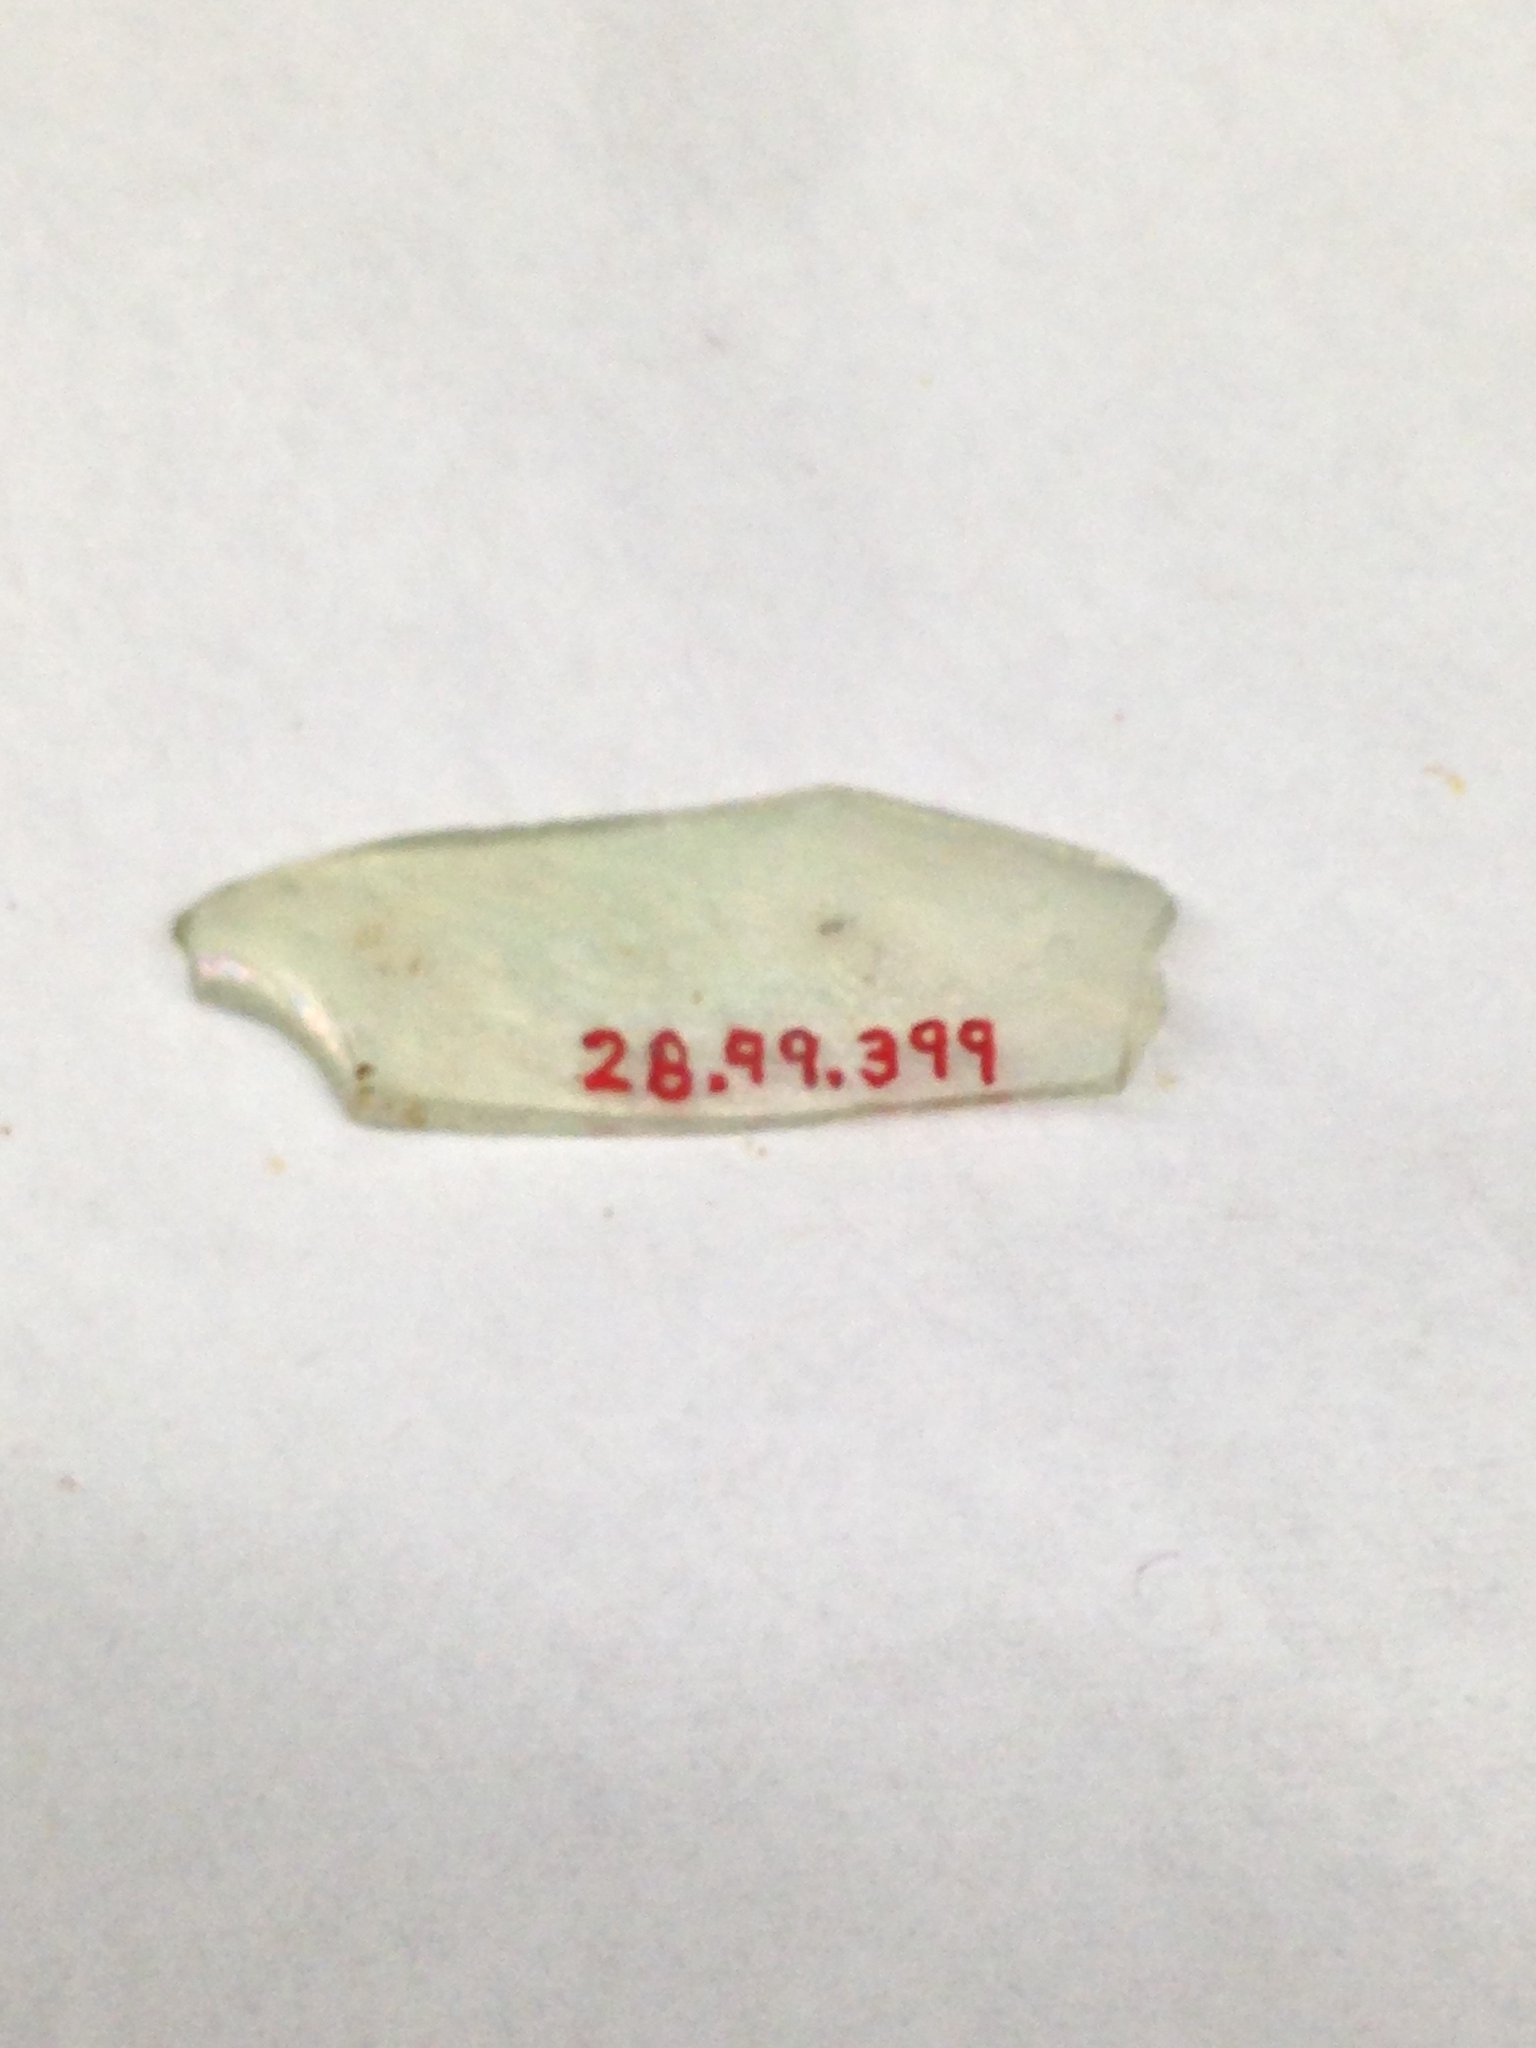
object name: fragment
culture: european or middle eastern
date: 1150-1250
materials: ceramic, glass